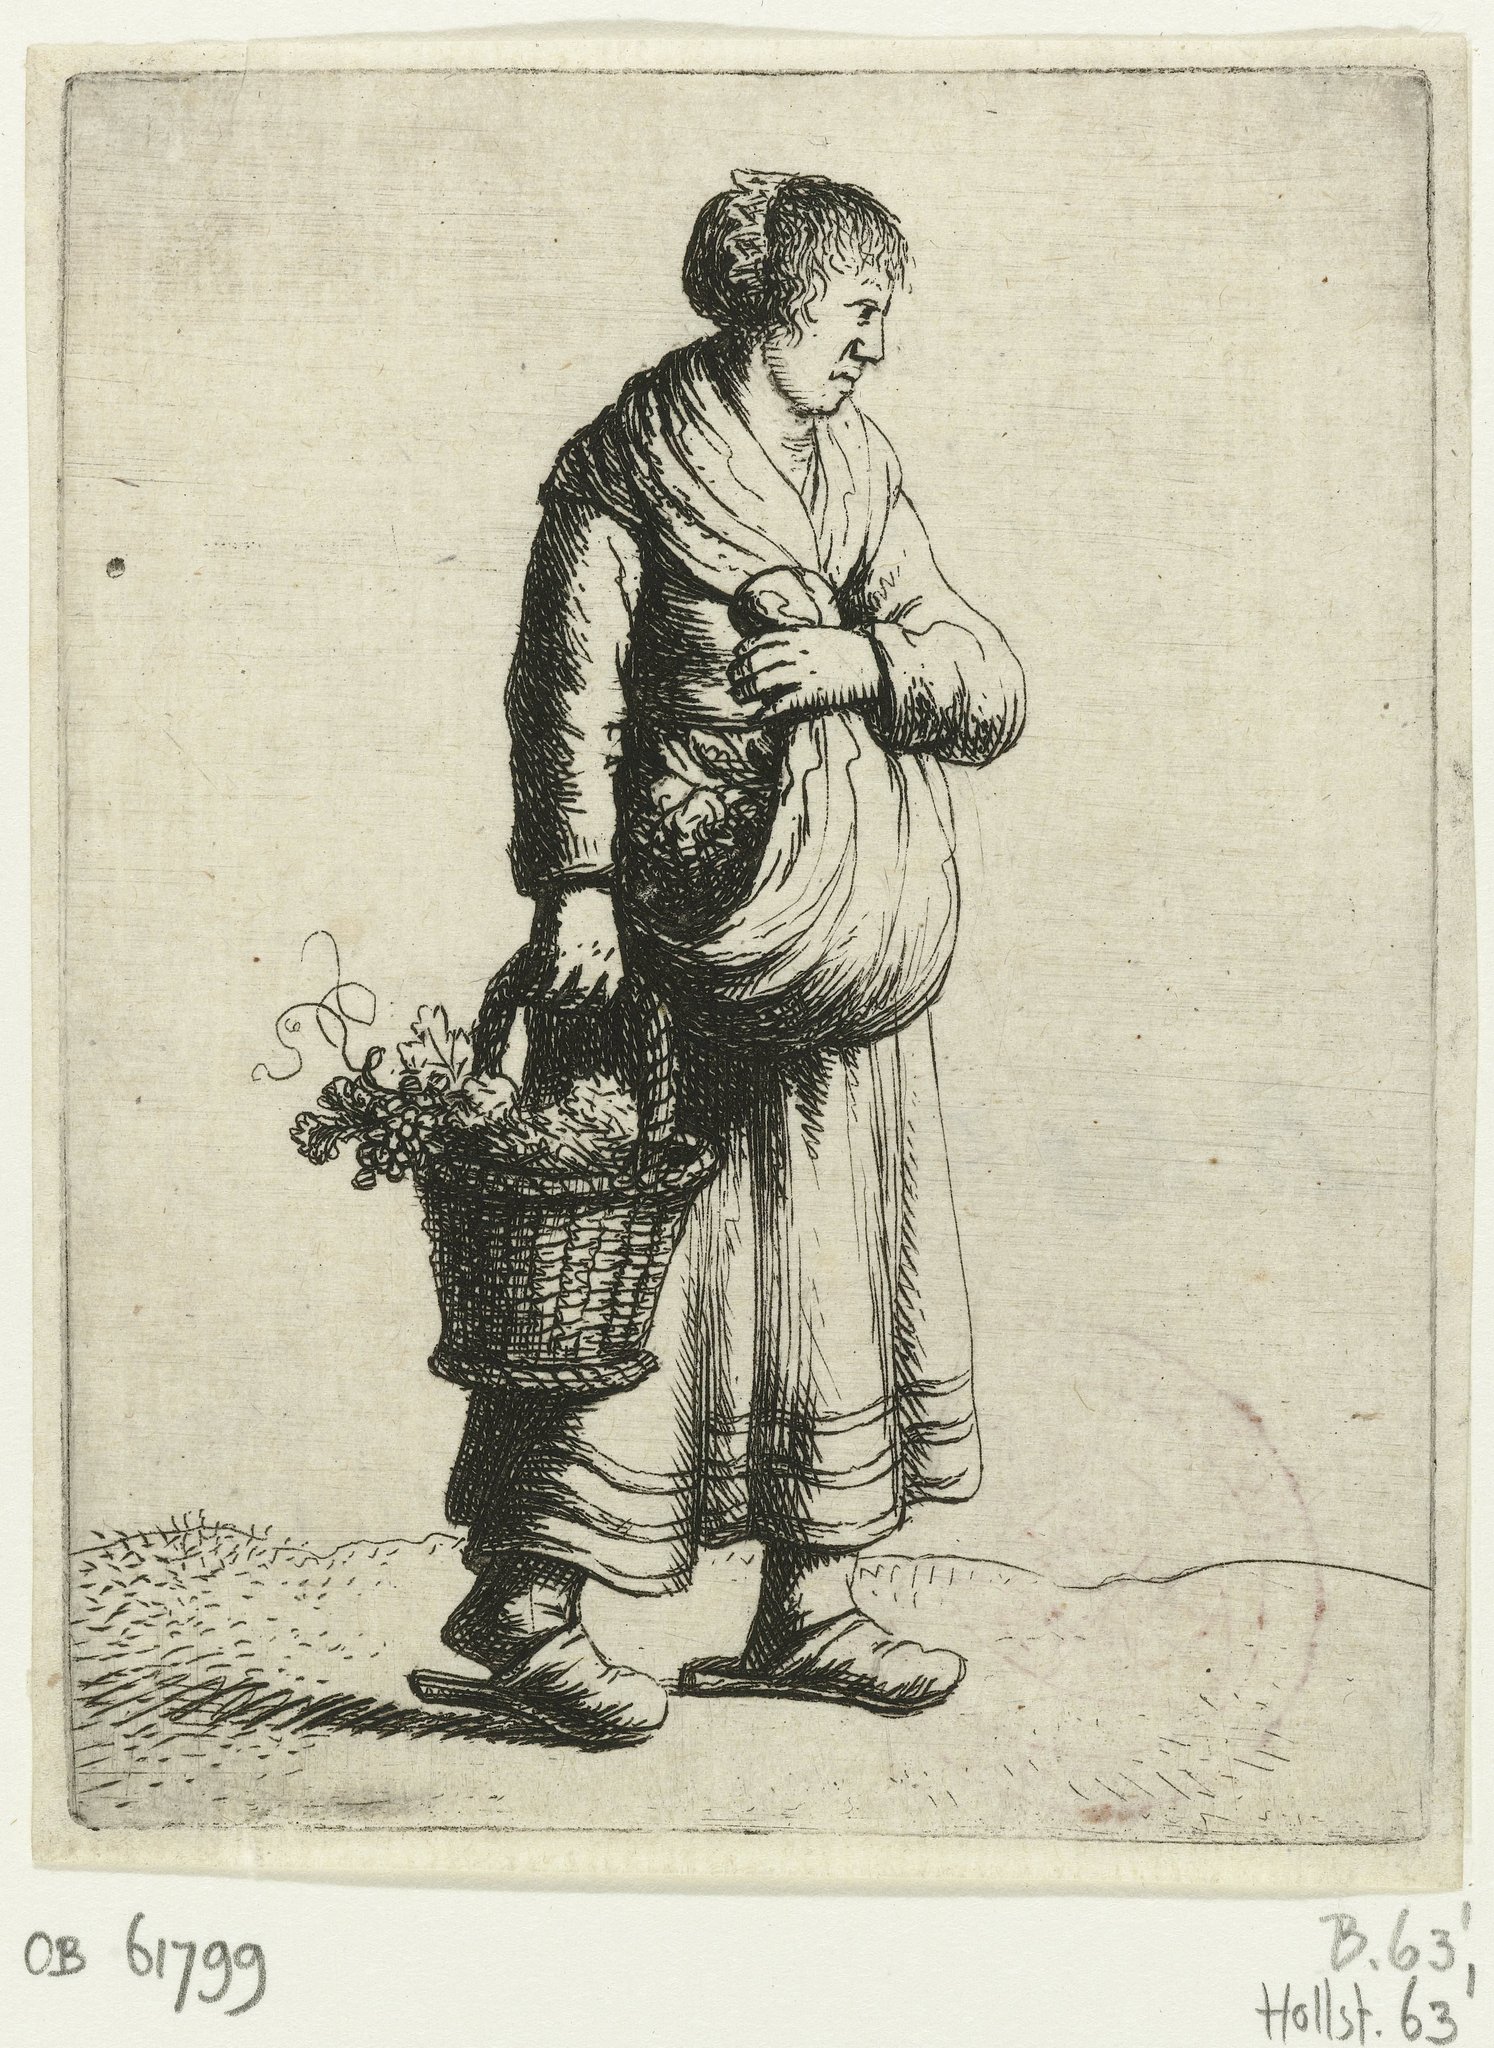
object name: print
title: Vrouw met mand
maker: jan gillisz. van vliet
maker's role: draughtsman, painter, print maker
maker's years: 1600-1668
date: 1635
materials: paper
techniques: etching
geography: leiden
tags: carrying something in basket, bag, rucksack, etc., container made of plant material other than wood: basket, apron (+ women's clothes)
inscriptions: collector's mark: Lugt 240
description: Een vrouw draagt groente en fruit in een mand en in haar schort dat zij ophoudt met haar linkerhand.